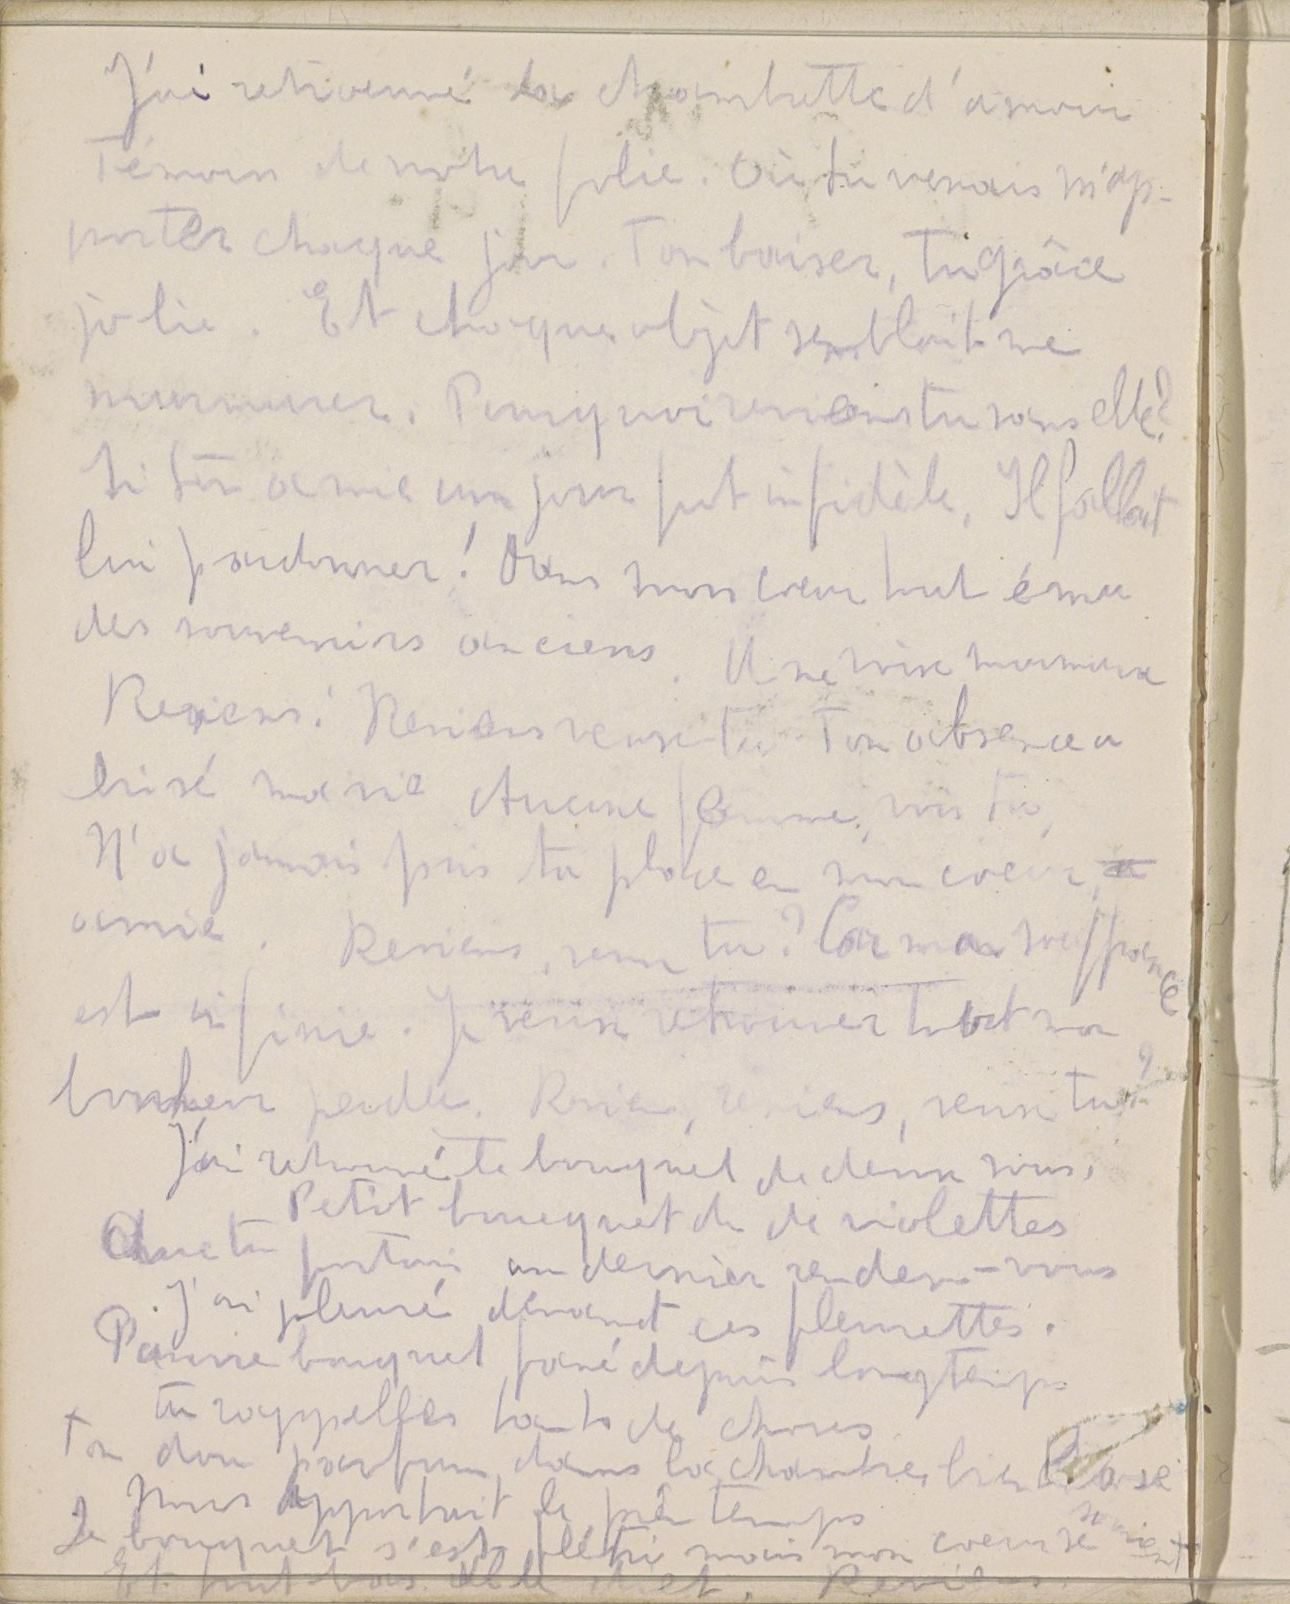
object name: sketchbook leaf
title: Notities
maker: reijer stolk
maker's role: draughtsman, print maker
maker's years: 1896-1945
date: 1916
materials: paper, pencil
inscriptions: annotation: ‘[...]’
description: Blad 71 verso uit een schetsboek met 72 bladen.